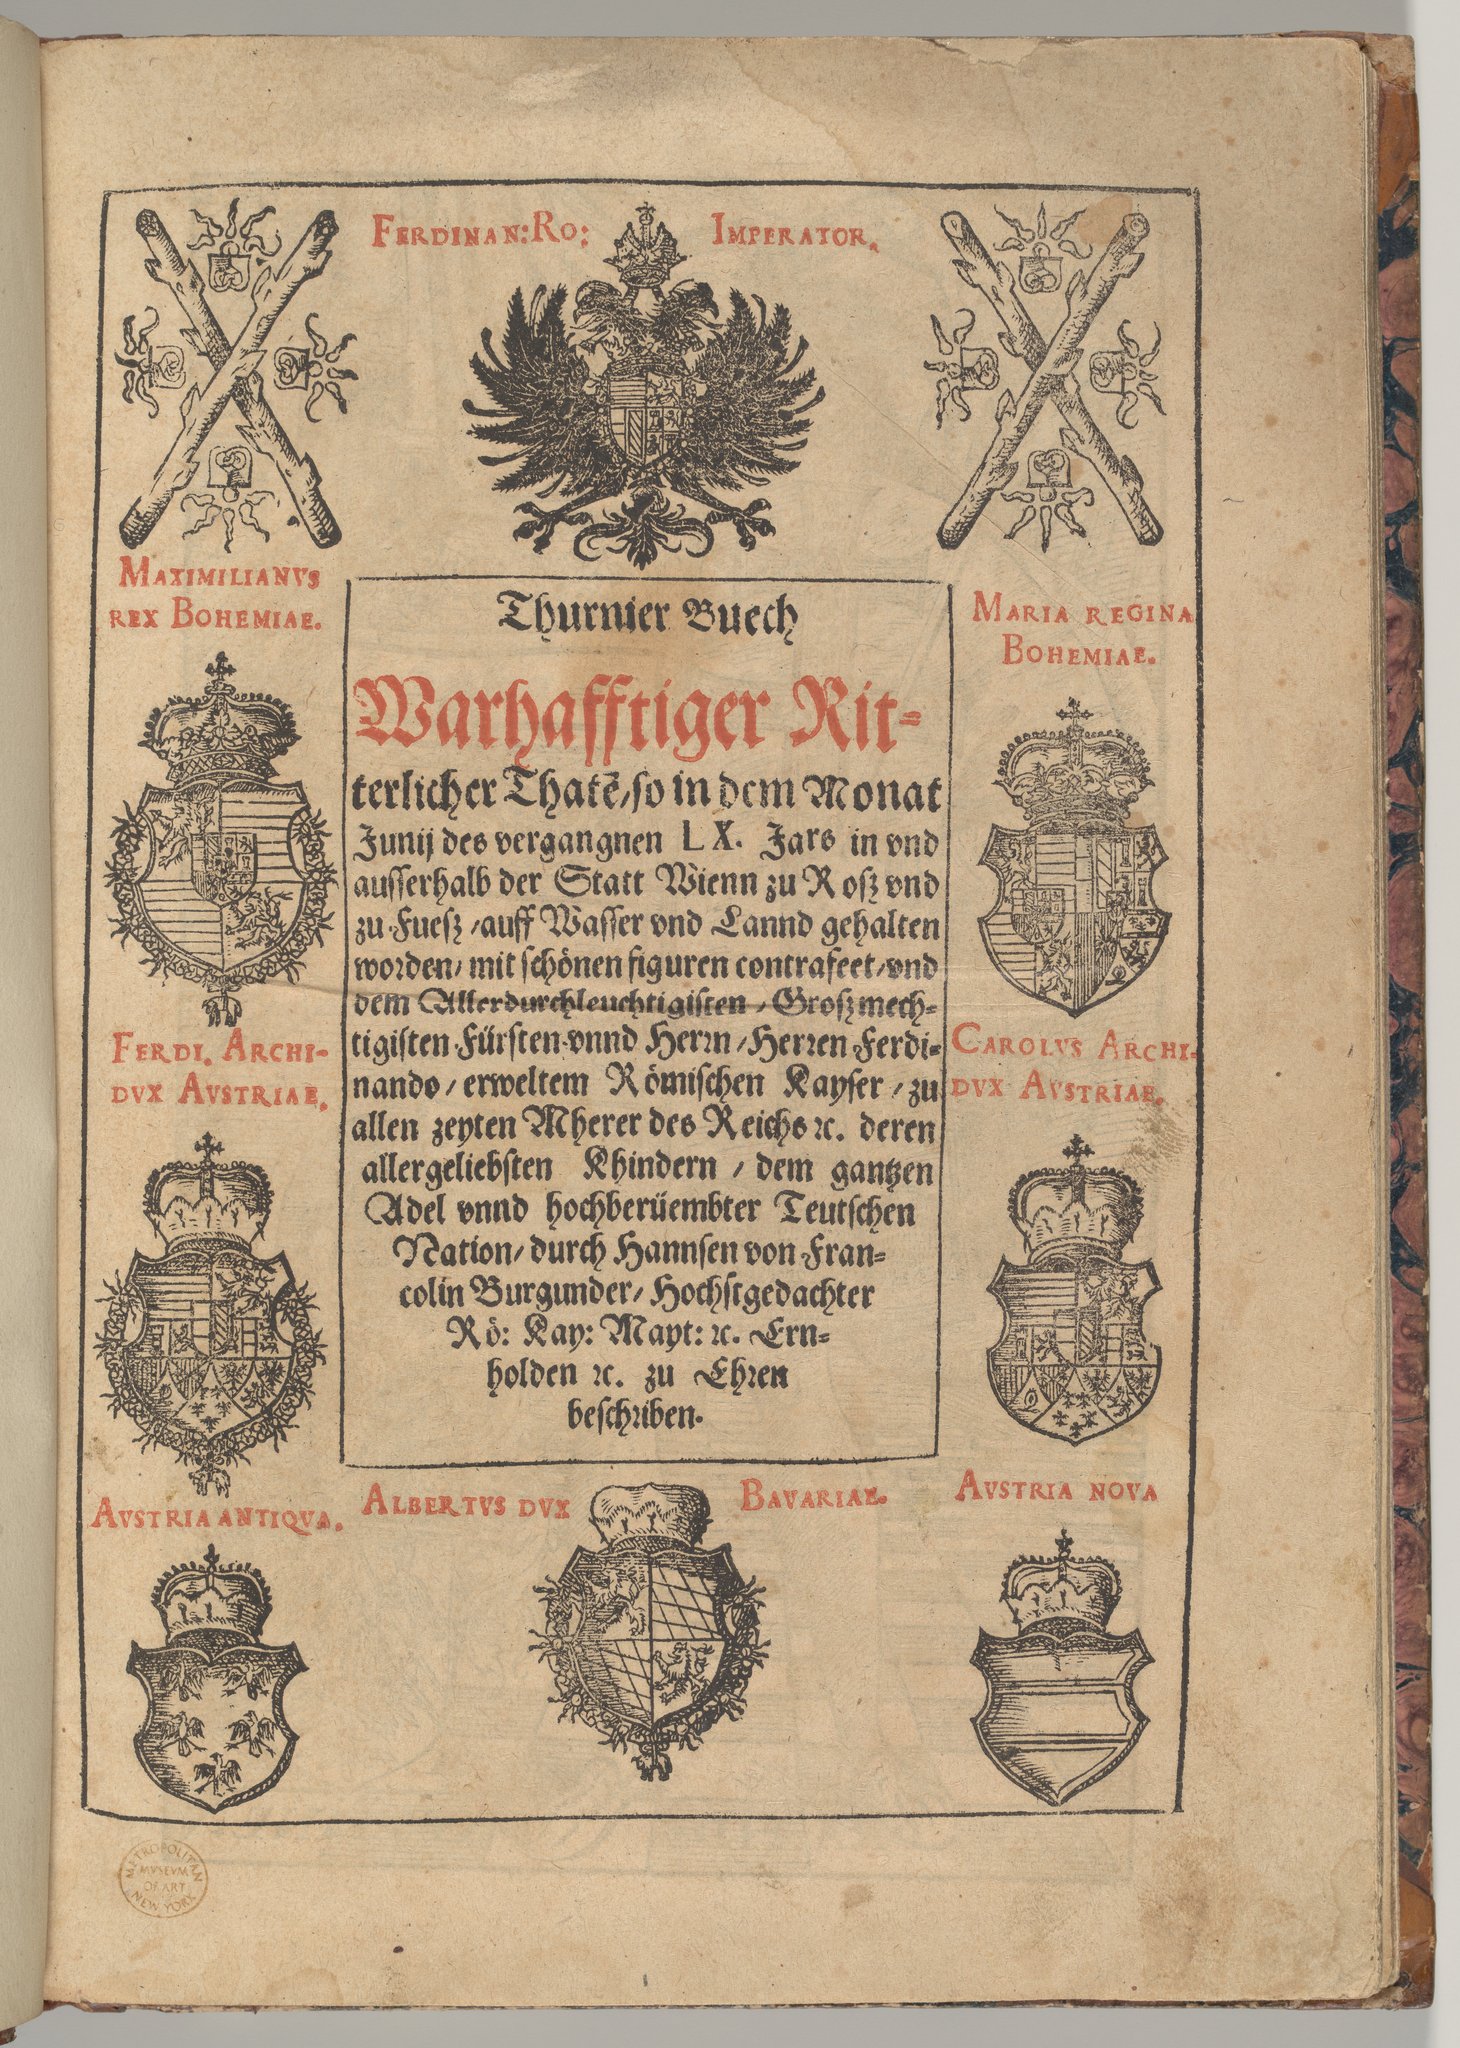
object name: book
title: Tournament Book of Knightly Acts (Thurnier Buech Warhafftiger Ritterlicher Thaten)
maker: hanns lautensack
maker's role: artist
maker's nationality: german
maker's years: 1515-1566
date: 1561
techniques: etching, letterpress, woodcut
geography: austria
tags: coat of arms